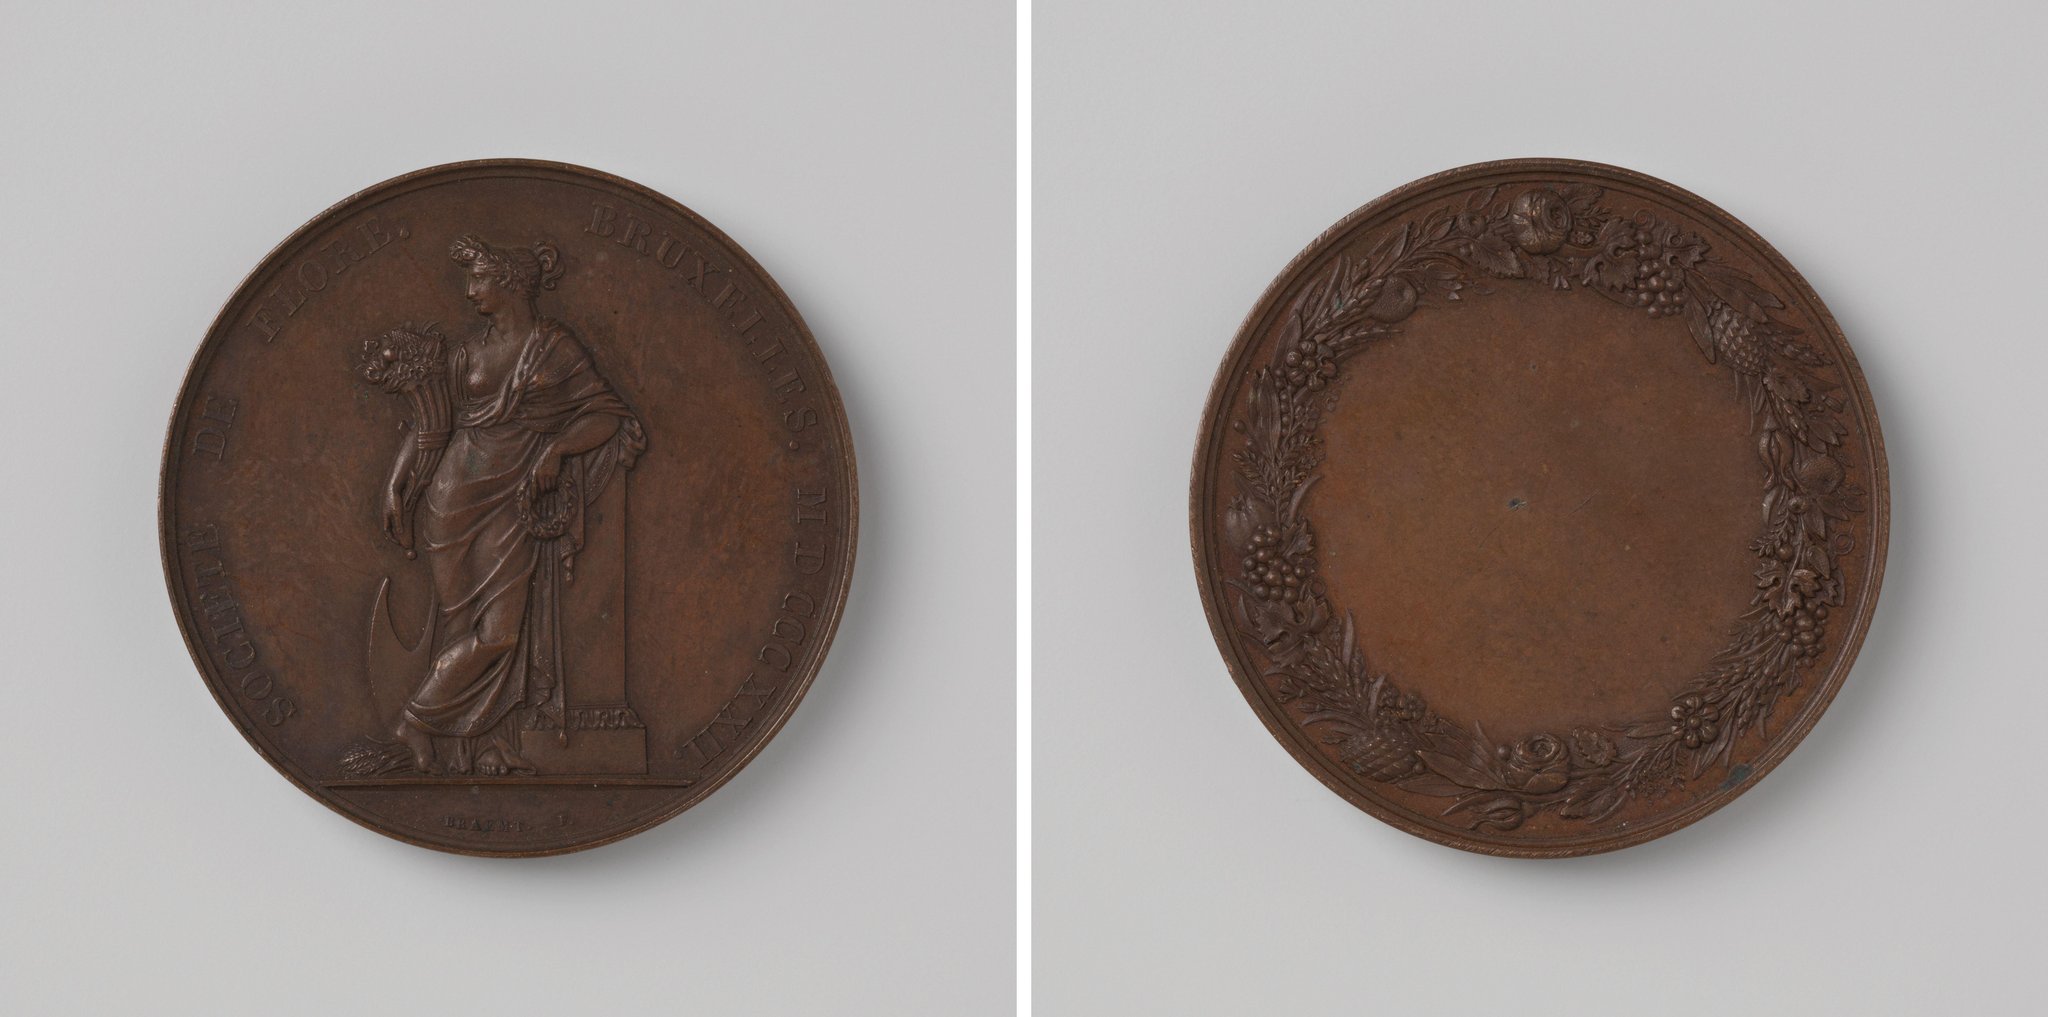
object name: medal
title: Societe de Flore te Brussel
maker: joseph pierre braemt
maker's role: print maker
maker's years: 1796-1864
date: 1822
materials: bronze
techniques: striking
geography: brussels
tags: brussels